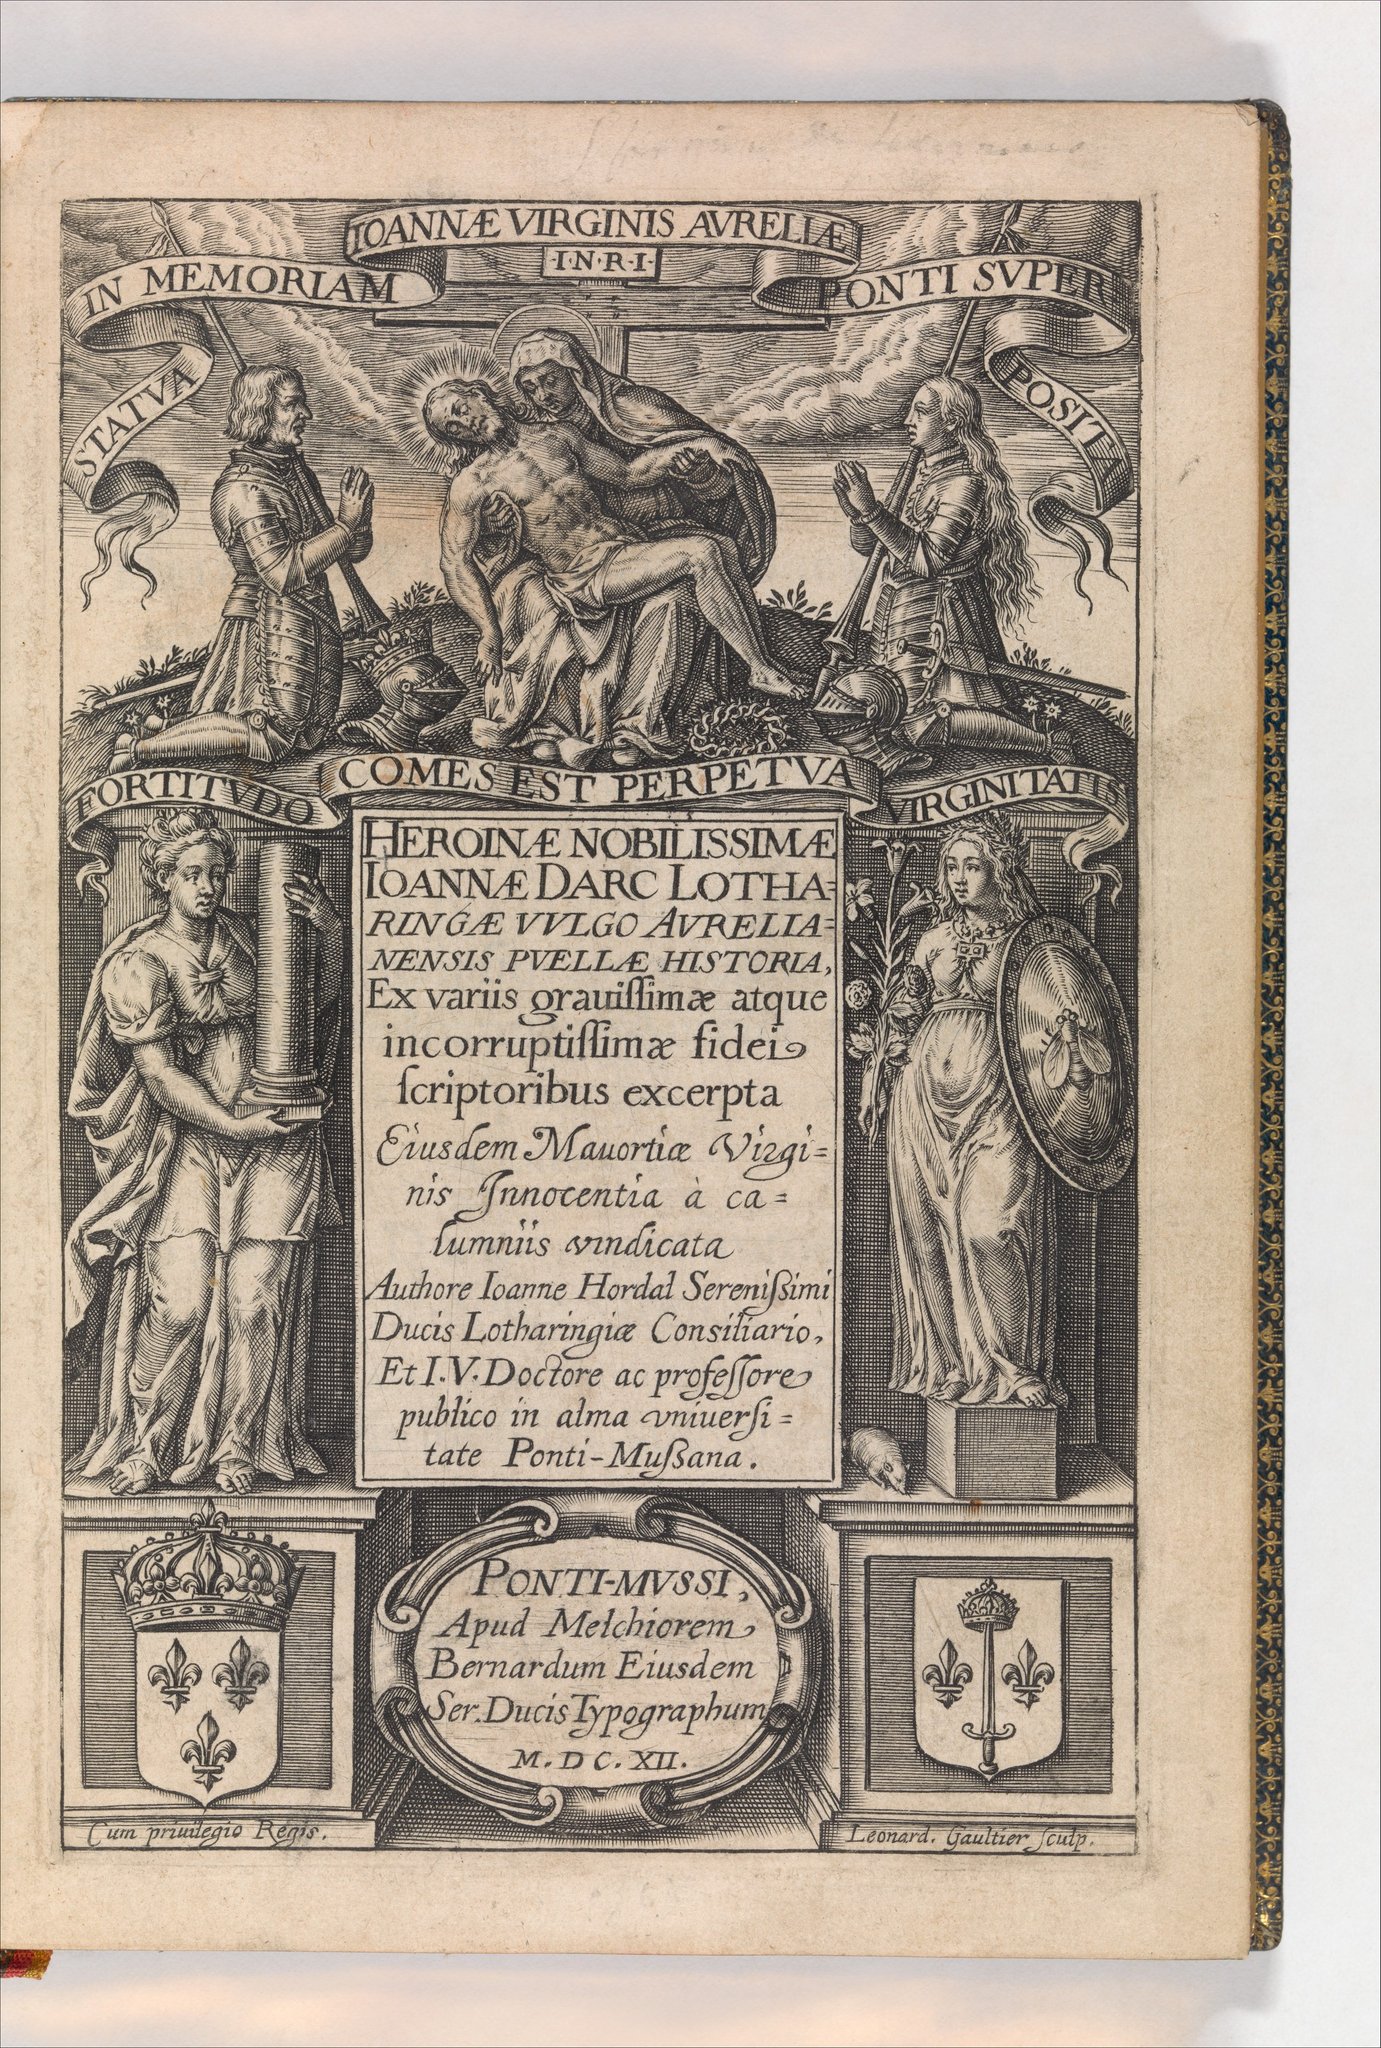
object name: book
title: Heroinae Nobilissimae Ioannae Darc Lotharingae...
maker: jean hordal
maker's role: author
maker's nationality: french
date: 1612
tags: shields,christ,virgin mary